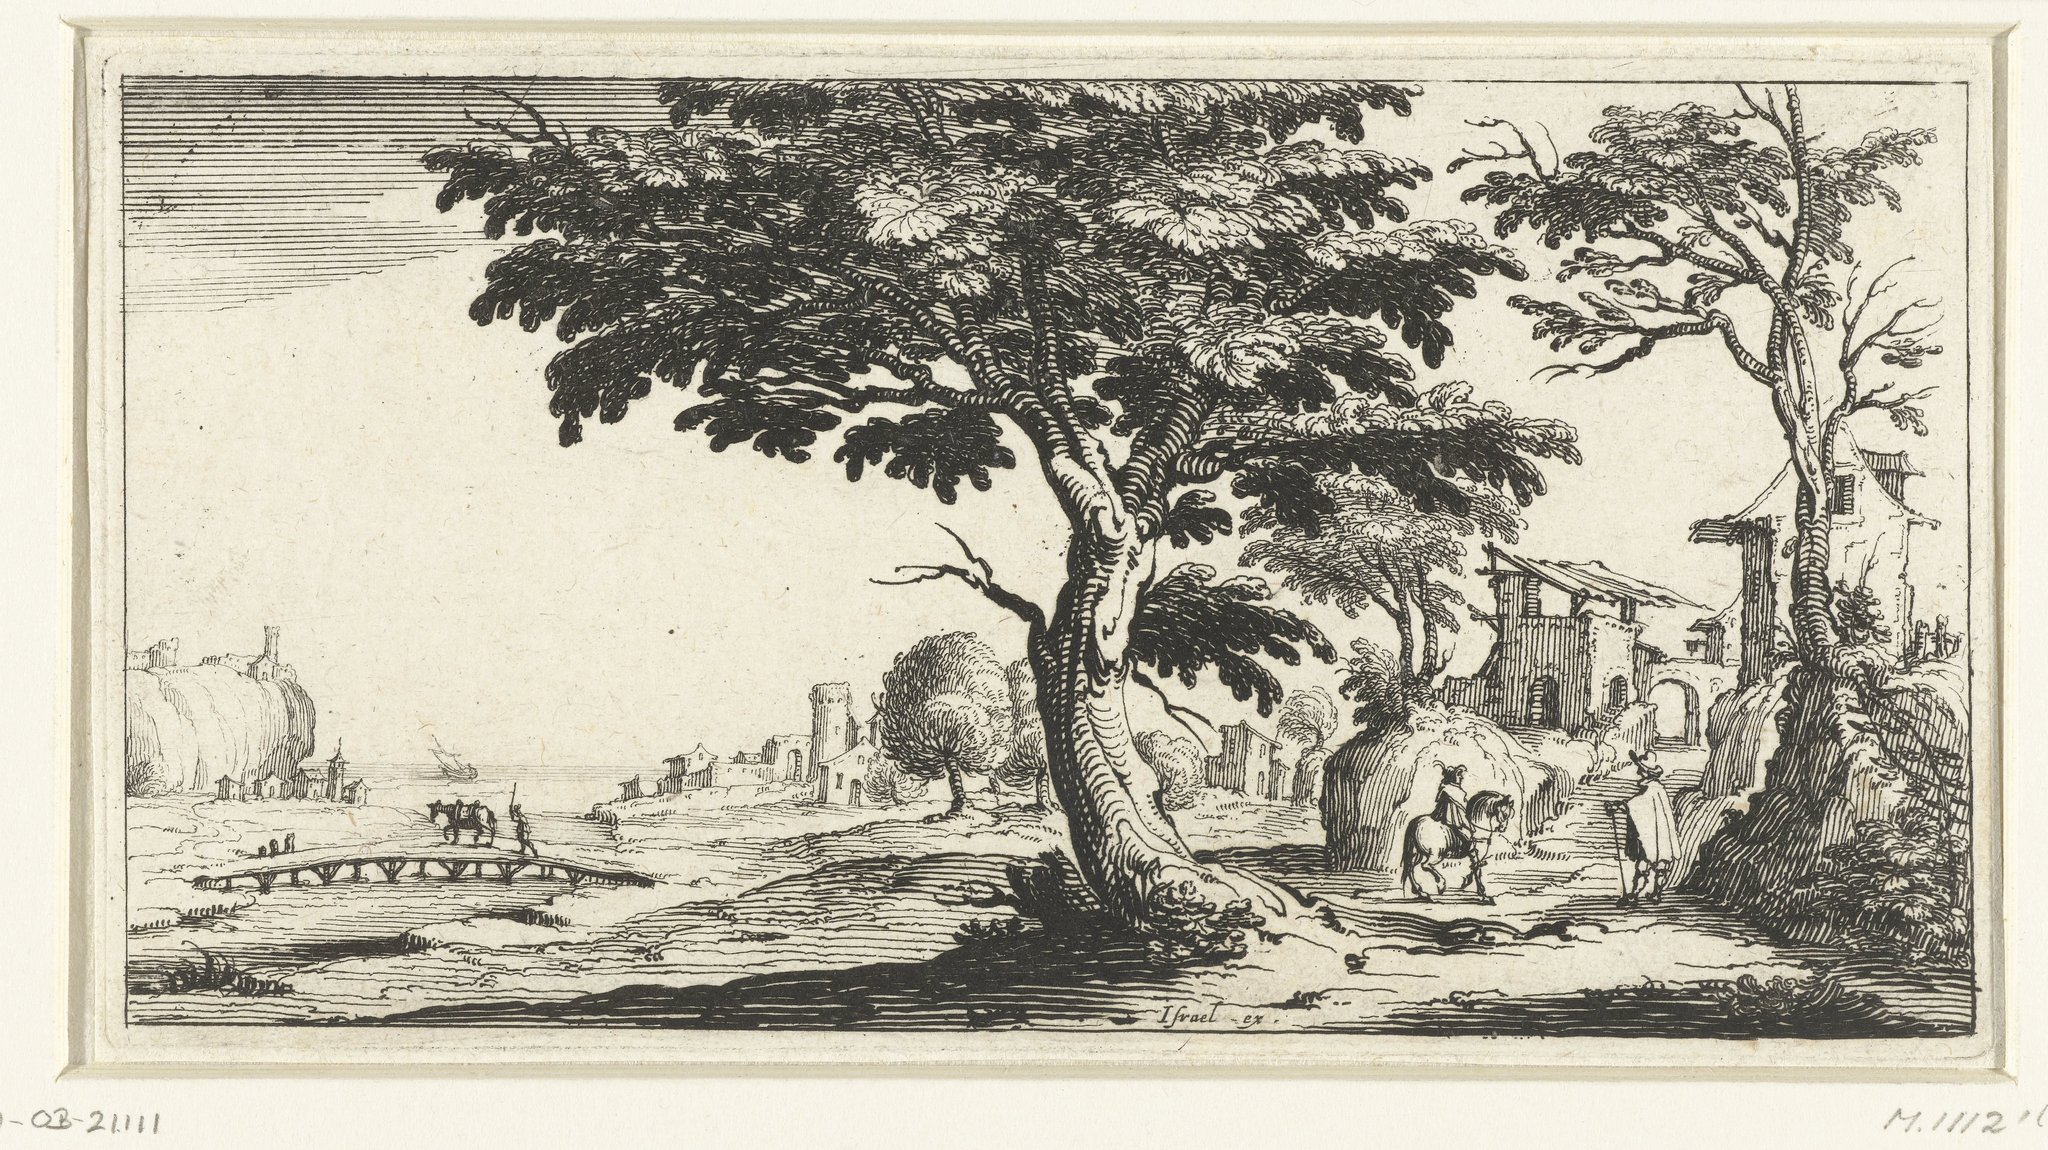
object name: print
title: Divers paisages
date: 1630-1660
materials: paper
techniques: etching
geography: france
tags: riding a horse, ass, or mule; rider, horseman, river bank, landscape with bridge, viaduct or aqueduct, village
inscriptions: collector's mark: Lugt 240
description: Landschap met enkele huisjes en een rivier die uitloopt in een baai of meer. Centraal op de voorgrond een grote boom. Rechts daarvan een ruiter en een wandelaar. Links op de achtergrond een brug. Deze prent is onderdeel van een serie van 19 prenten (20 incl. titelprent) met landschappen.